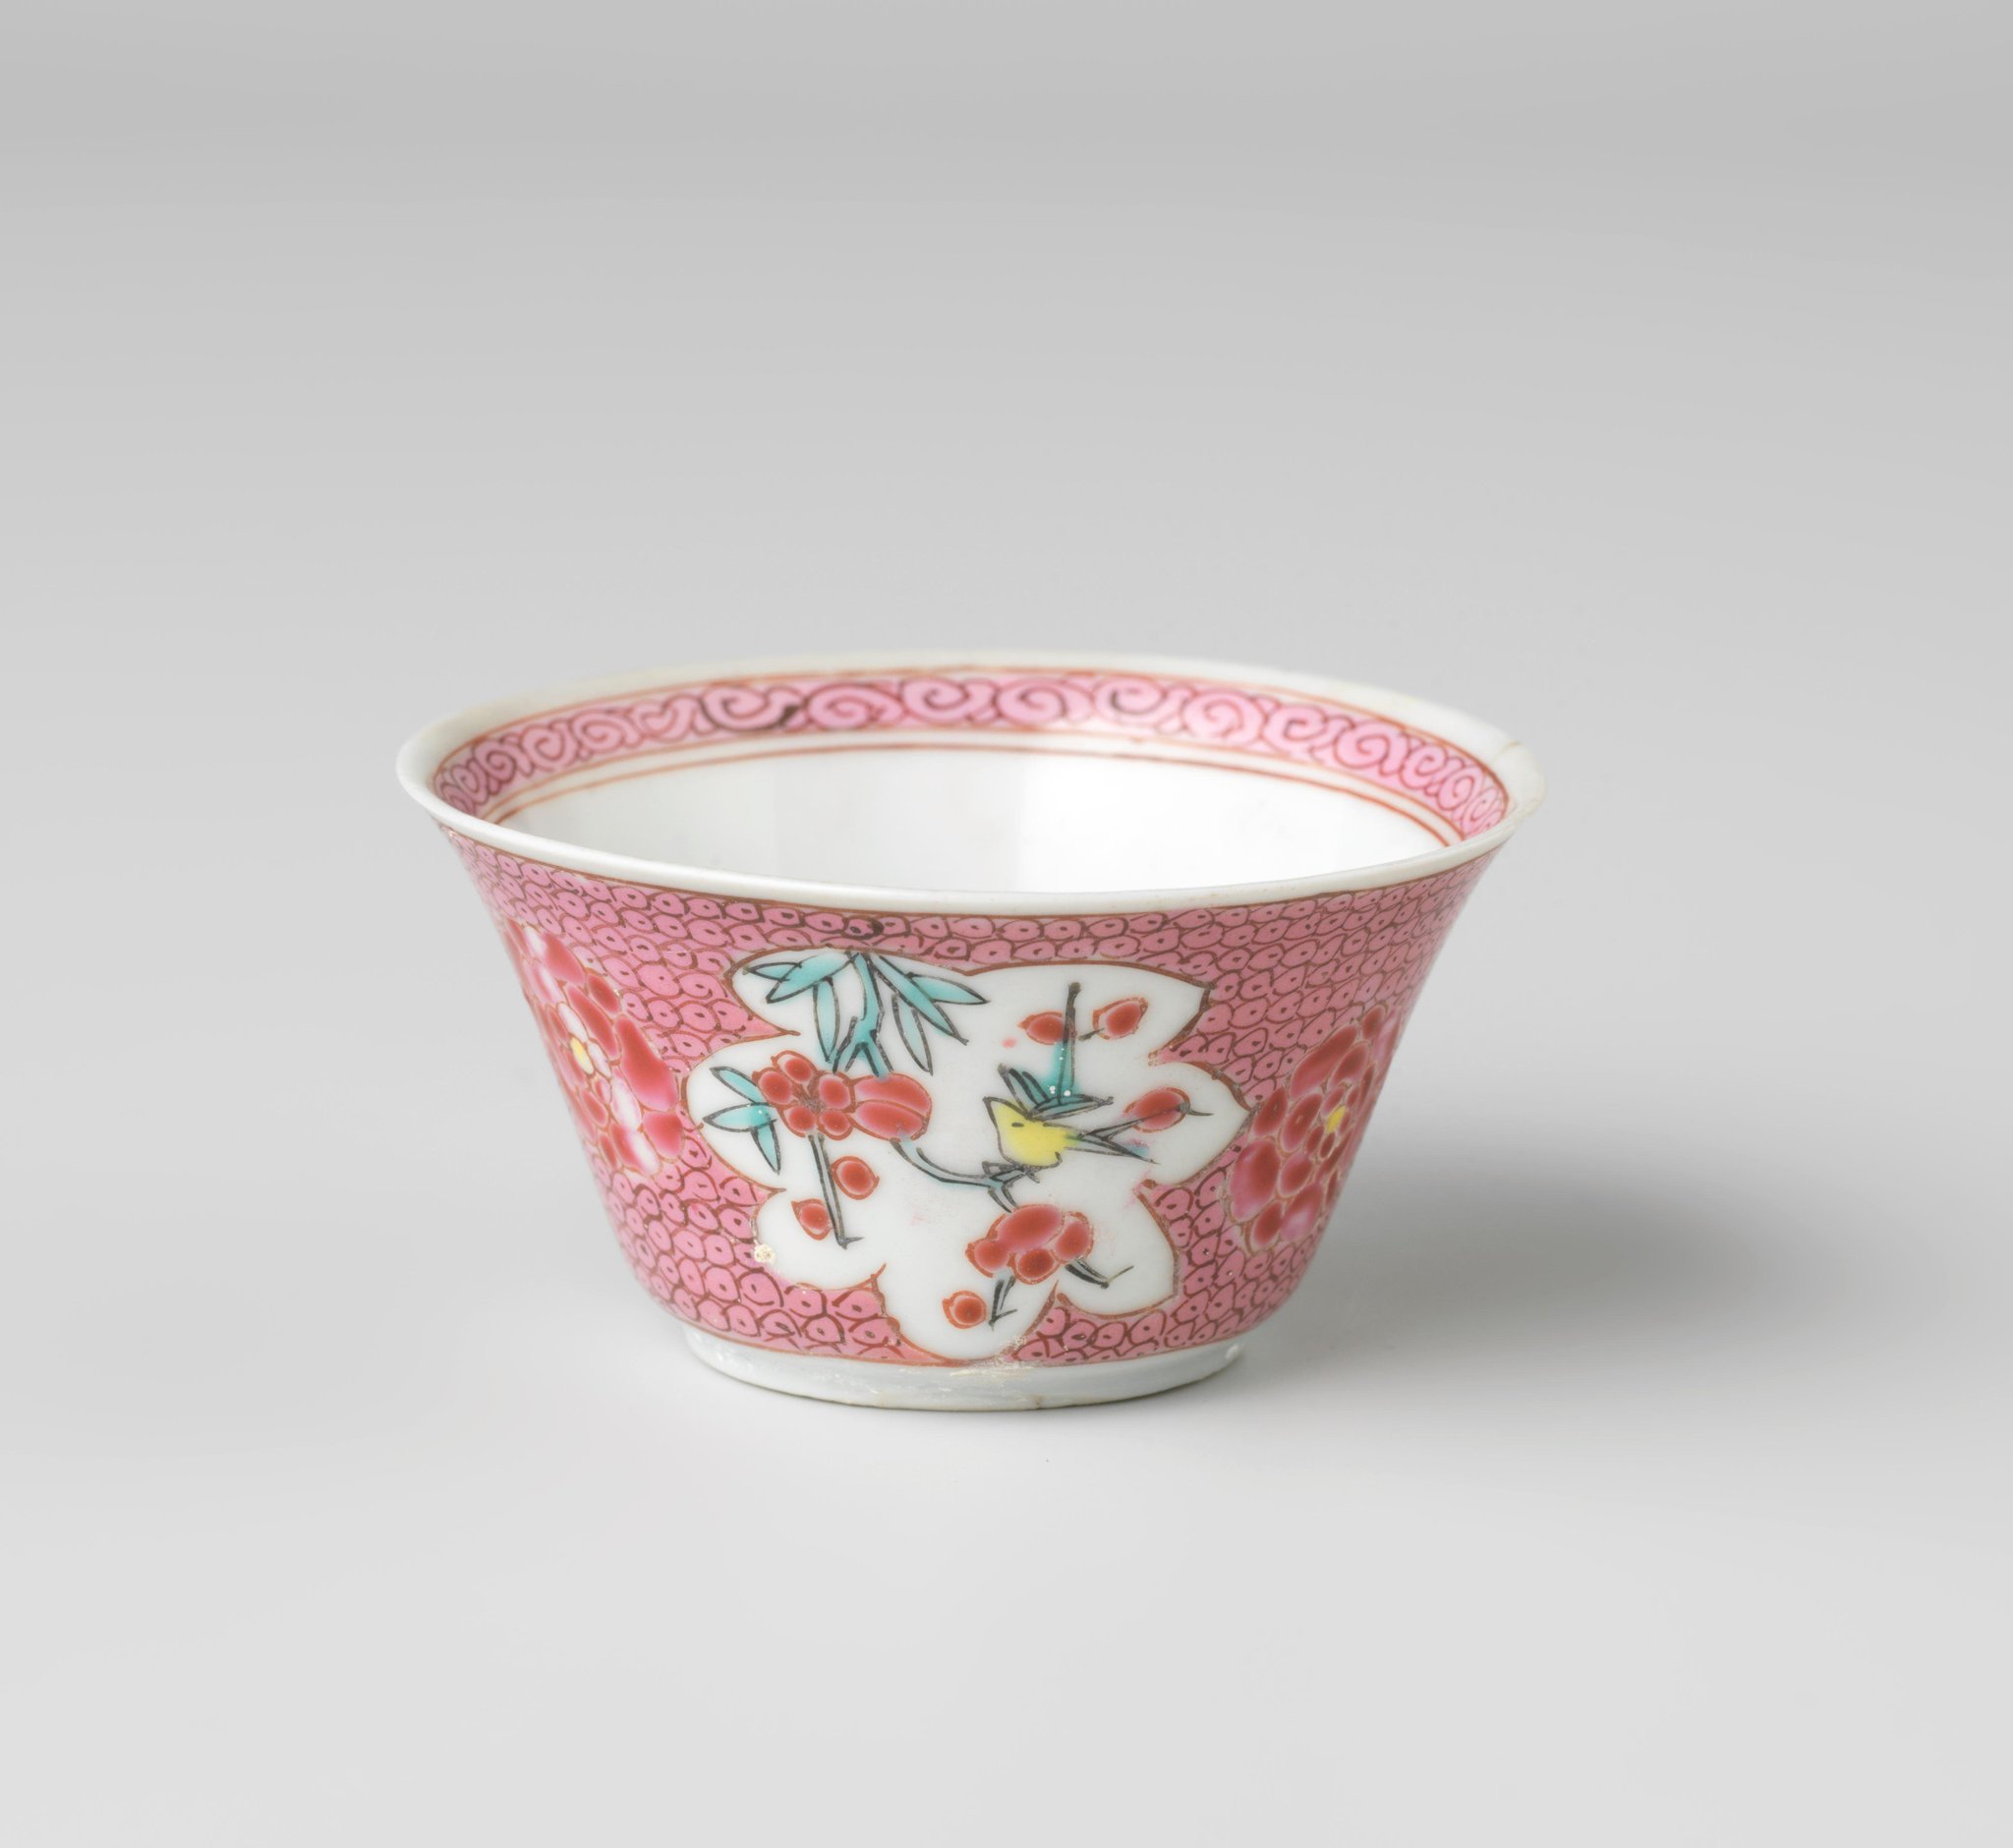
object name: kop en schotel, kop en schotel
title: Cup with a woman and boy in a landscape and flower sprays on diaper-pattern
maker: Anonymous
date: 1725-1749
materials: glaze, gold, paint, porcelain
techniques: firing, gilding, turning, vitrification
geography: china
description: Kop en schotel, famille rose, versierd met vrouw en kind spelend met een konijn.